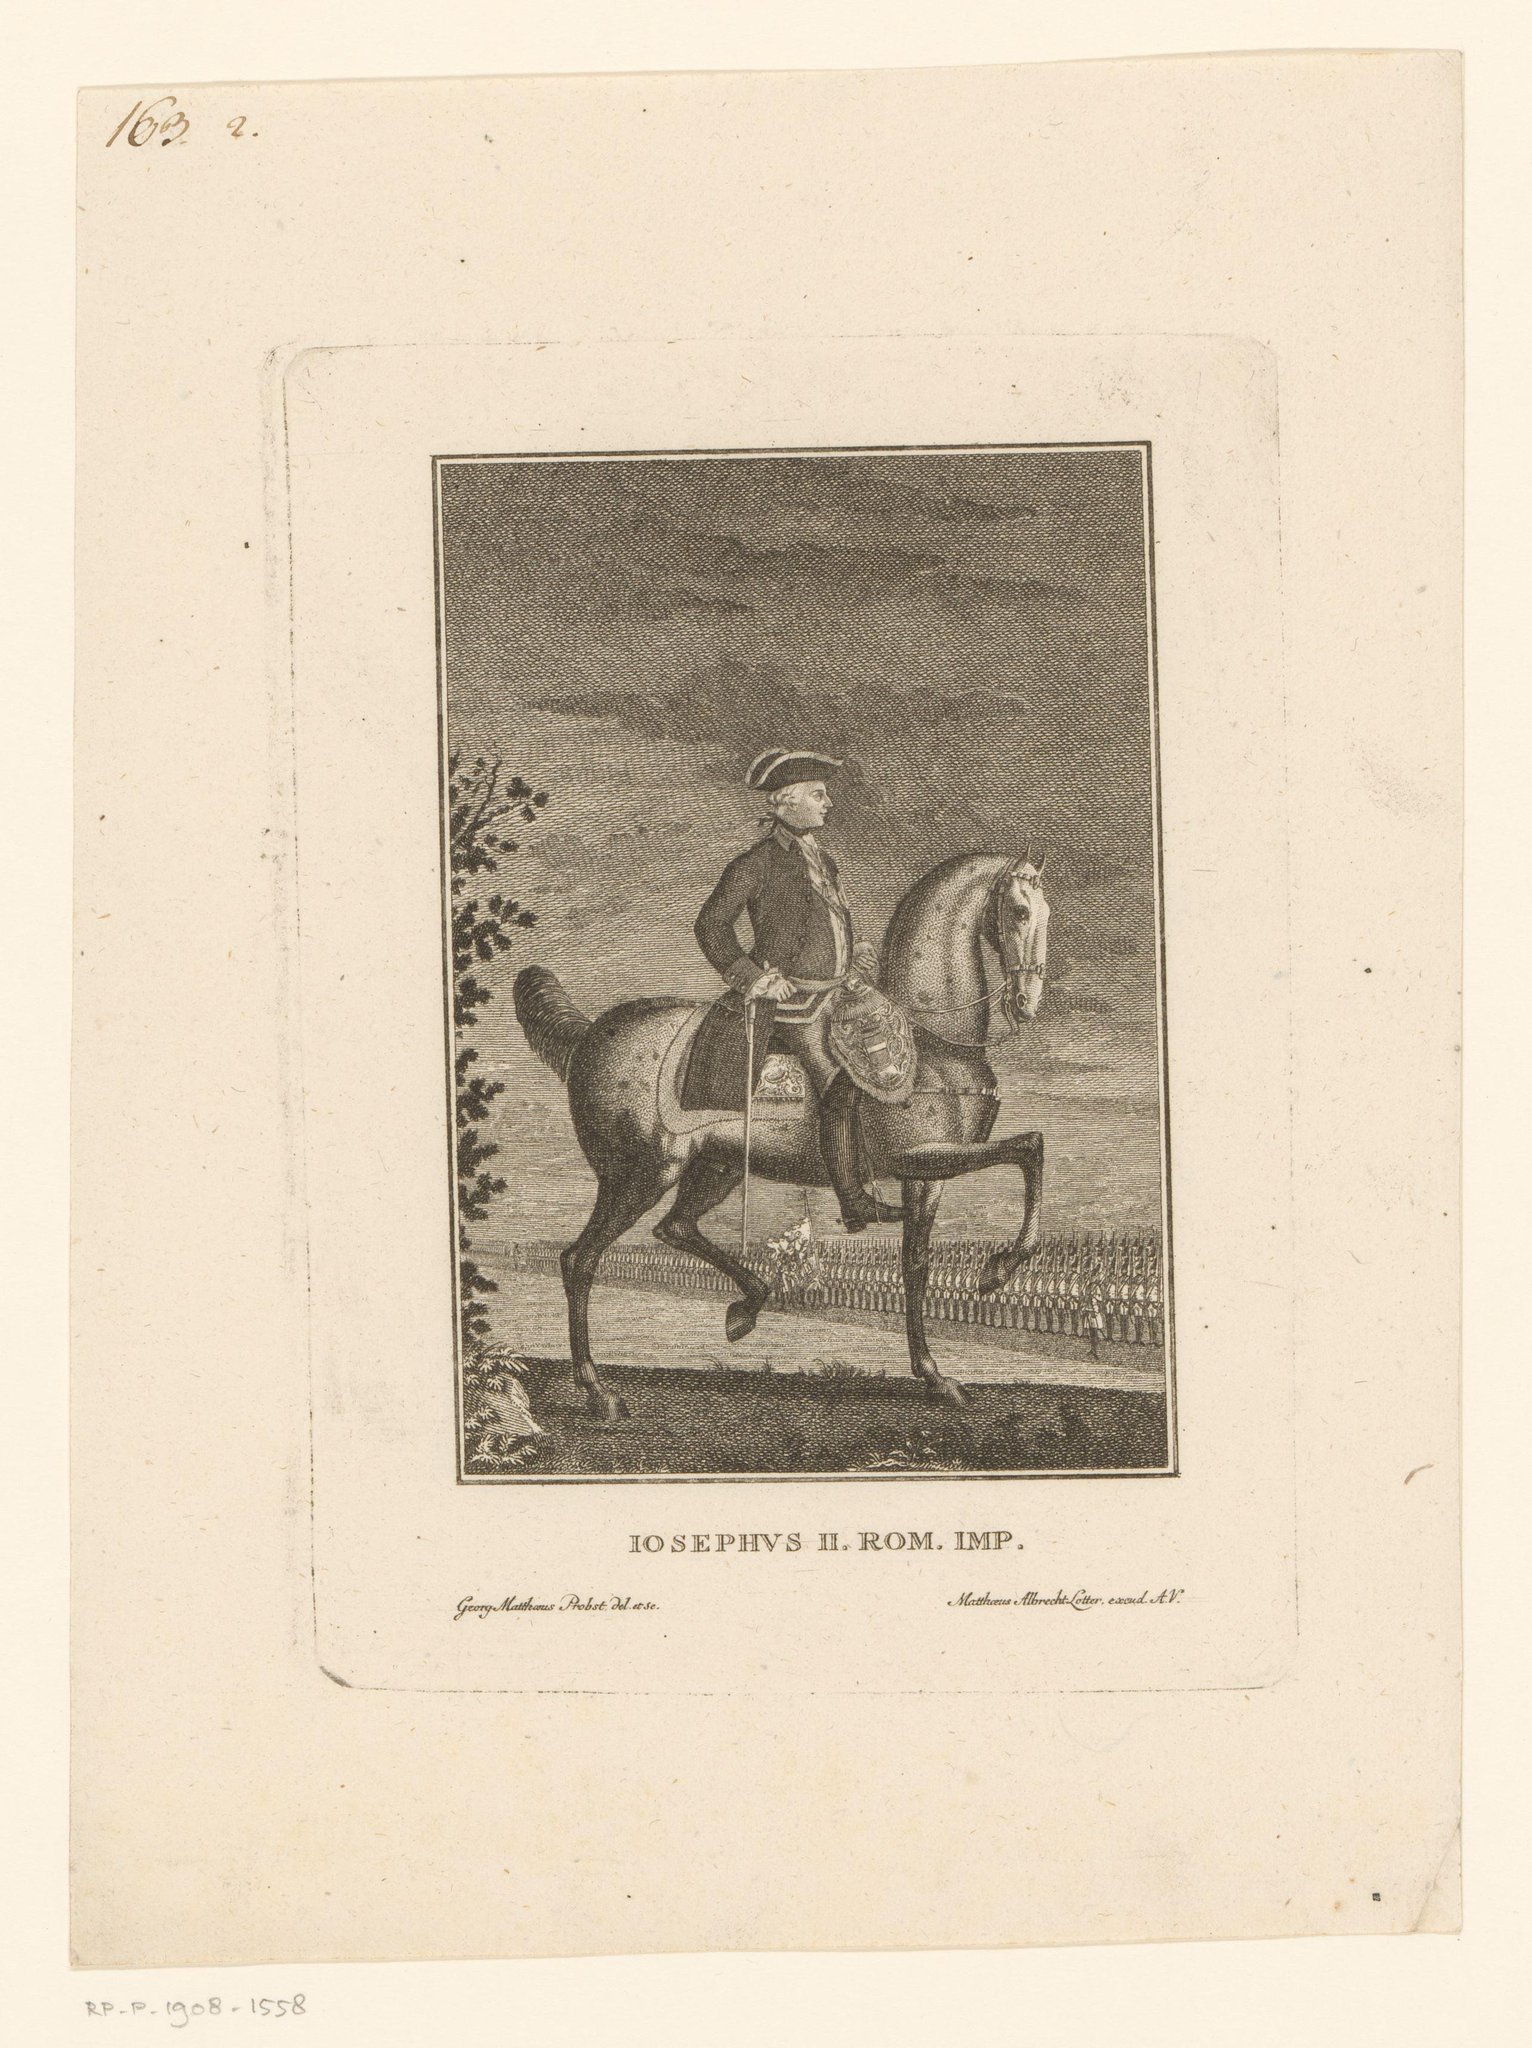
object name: print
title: Ruiterportret van Jozef II, Duits keizer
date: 1765-1772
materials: paper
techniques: engraving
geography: augsburg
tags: vienna, jozef ii (duits keizer), historical persons, land forces, armorial bearing, heraldry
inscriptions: number: ‘163 2.’, collector's mark: Lugt 2228